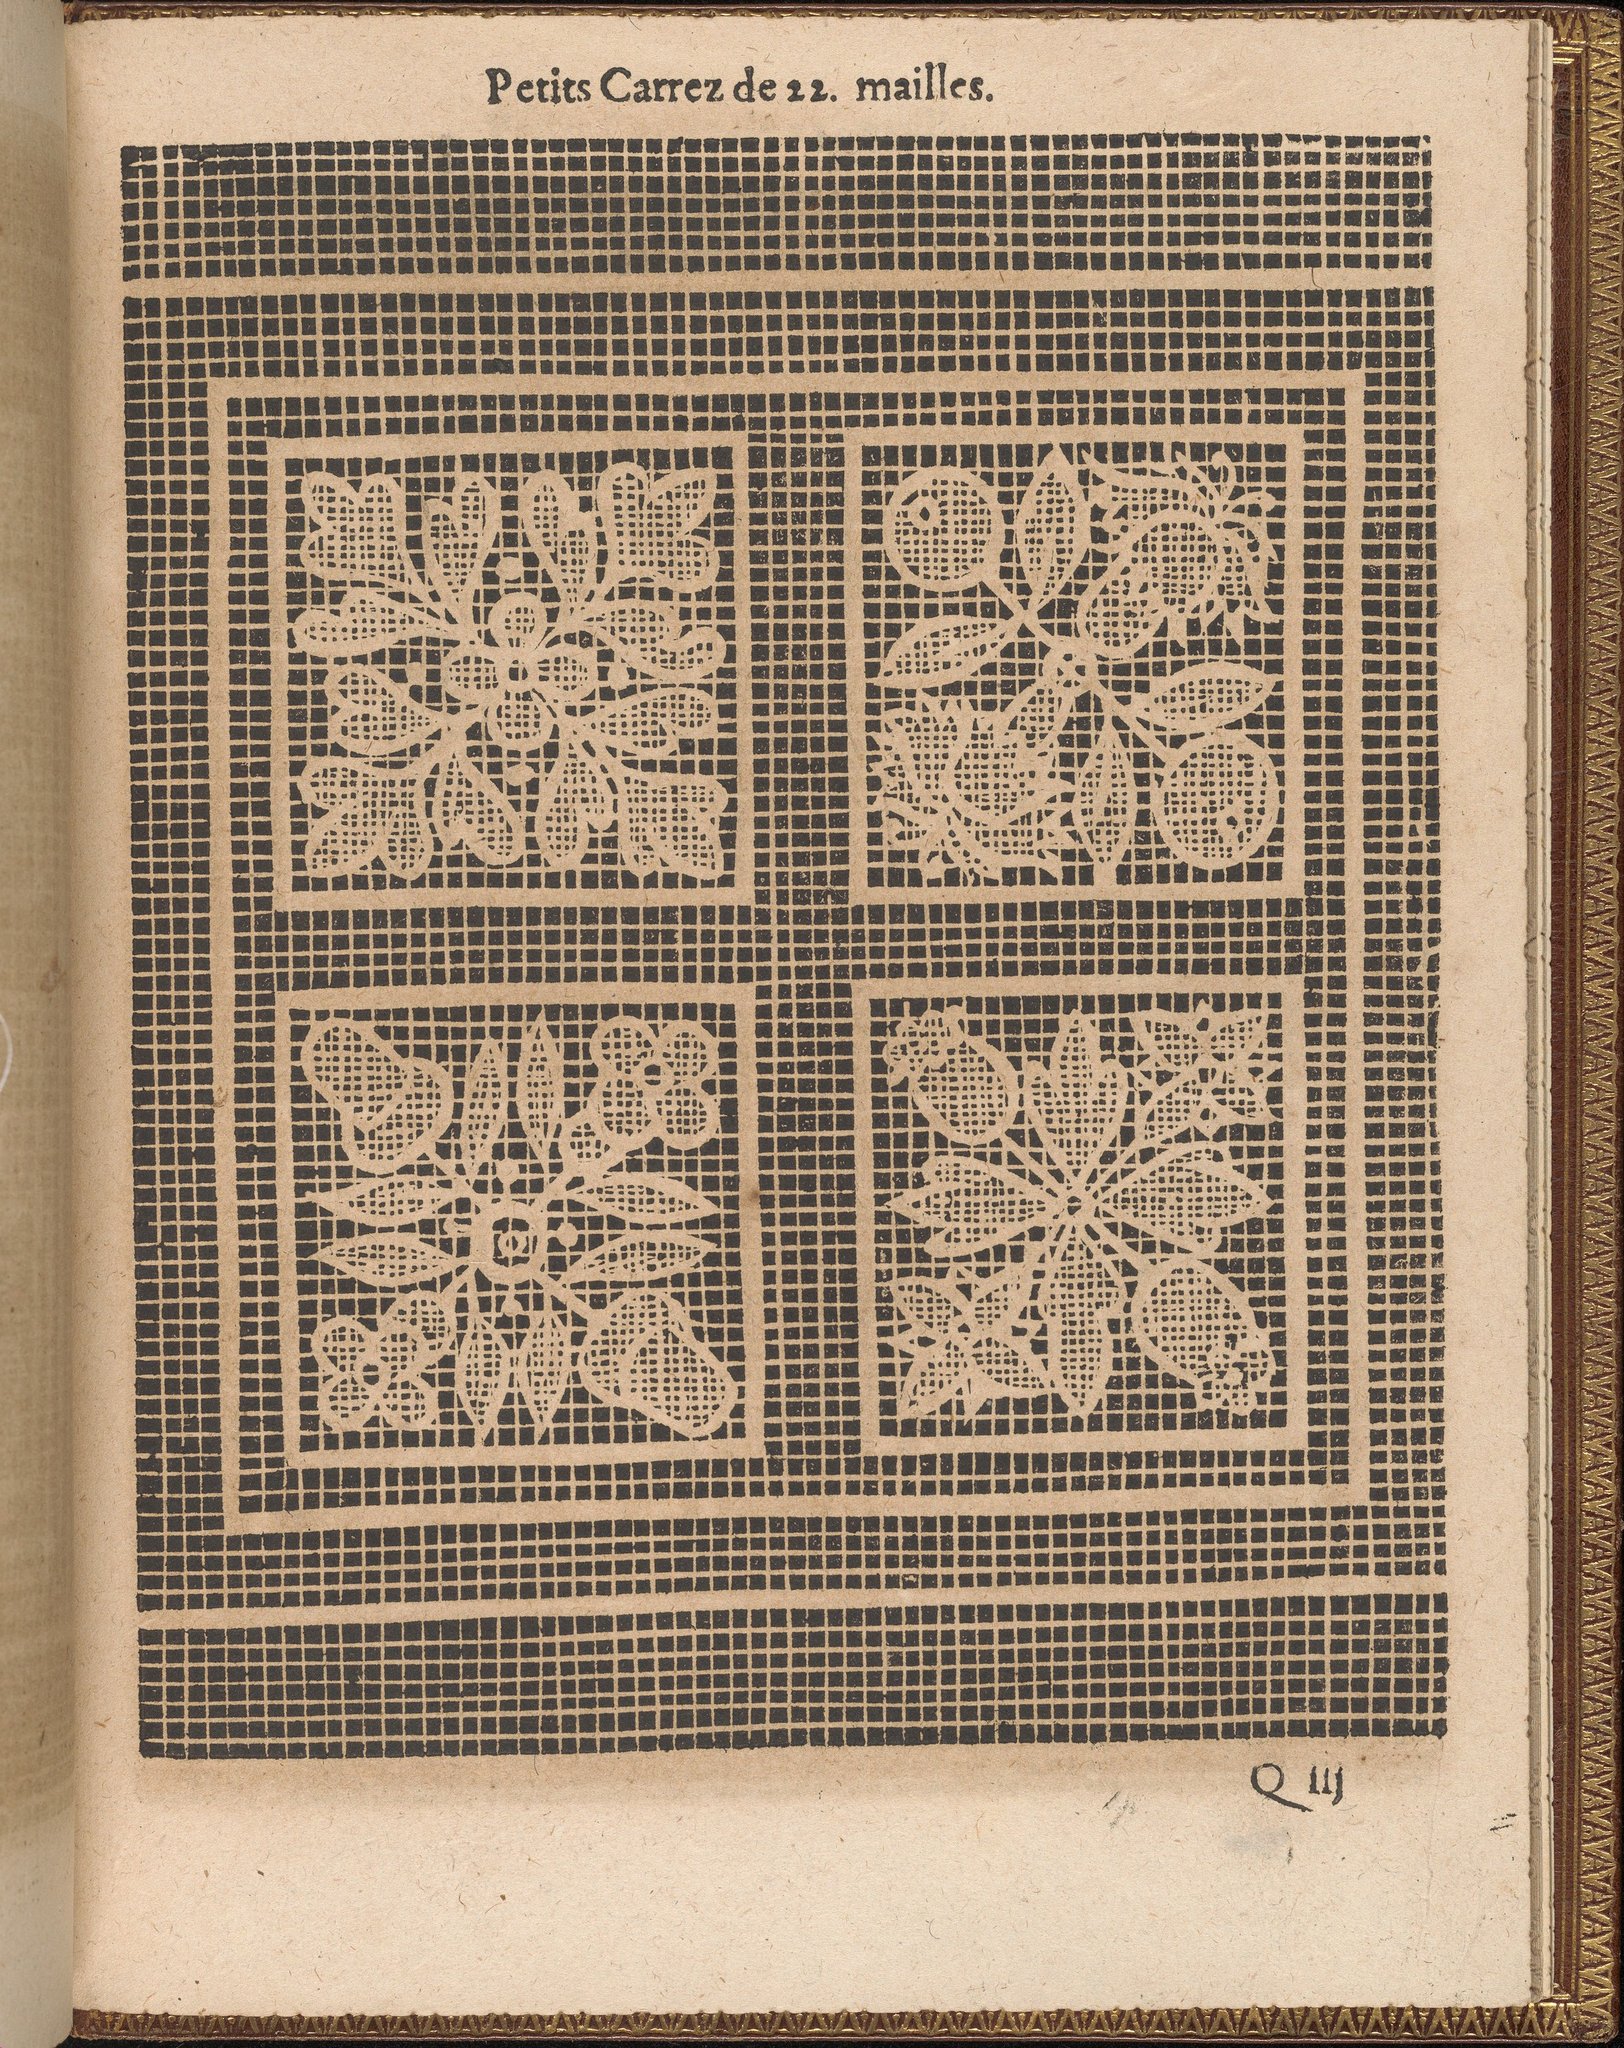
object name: book print ornament architecture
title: La Pratique de l'Aiguille, page 62 (recto)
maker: matthias mignerak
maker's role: author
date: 1605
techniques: woodcut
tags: flowers